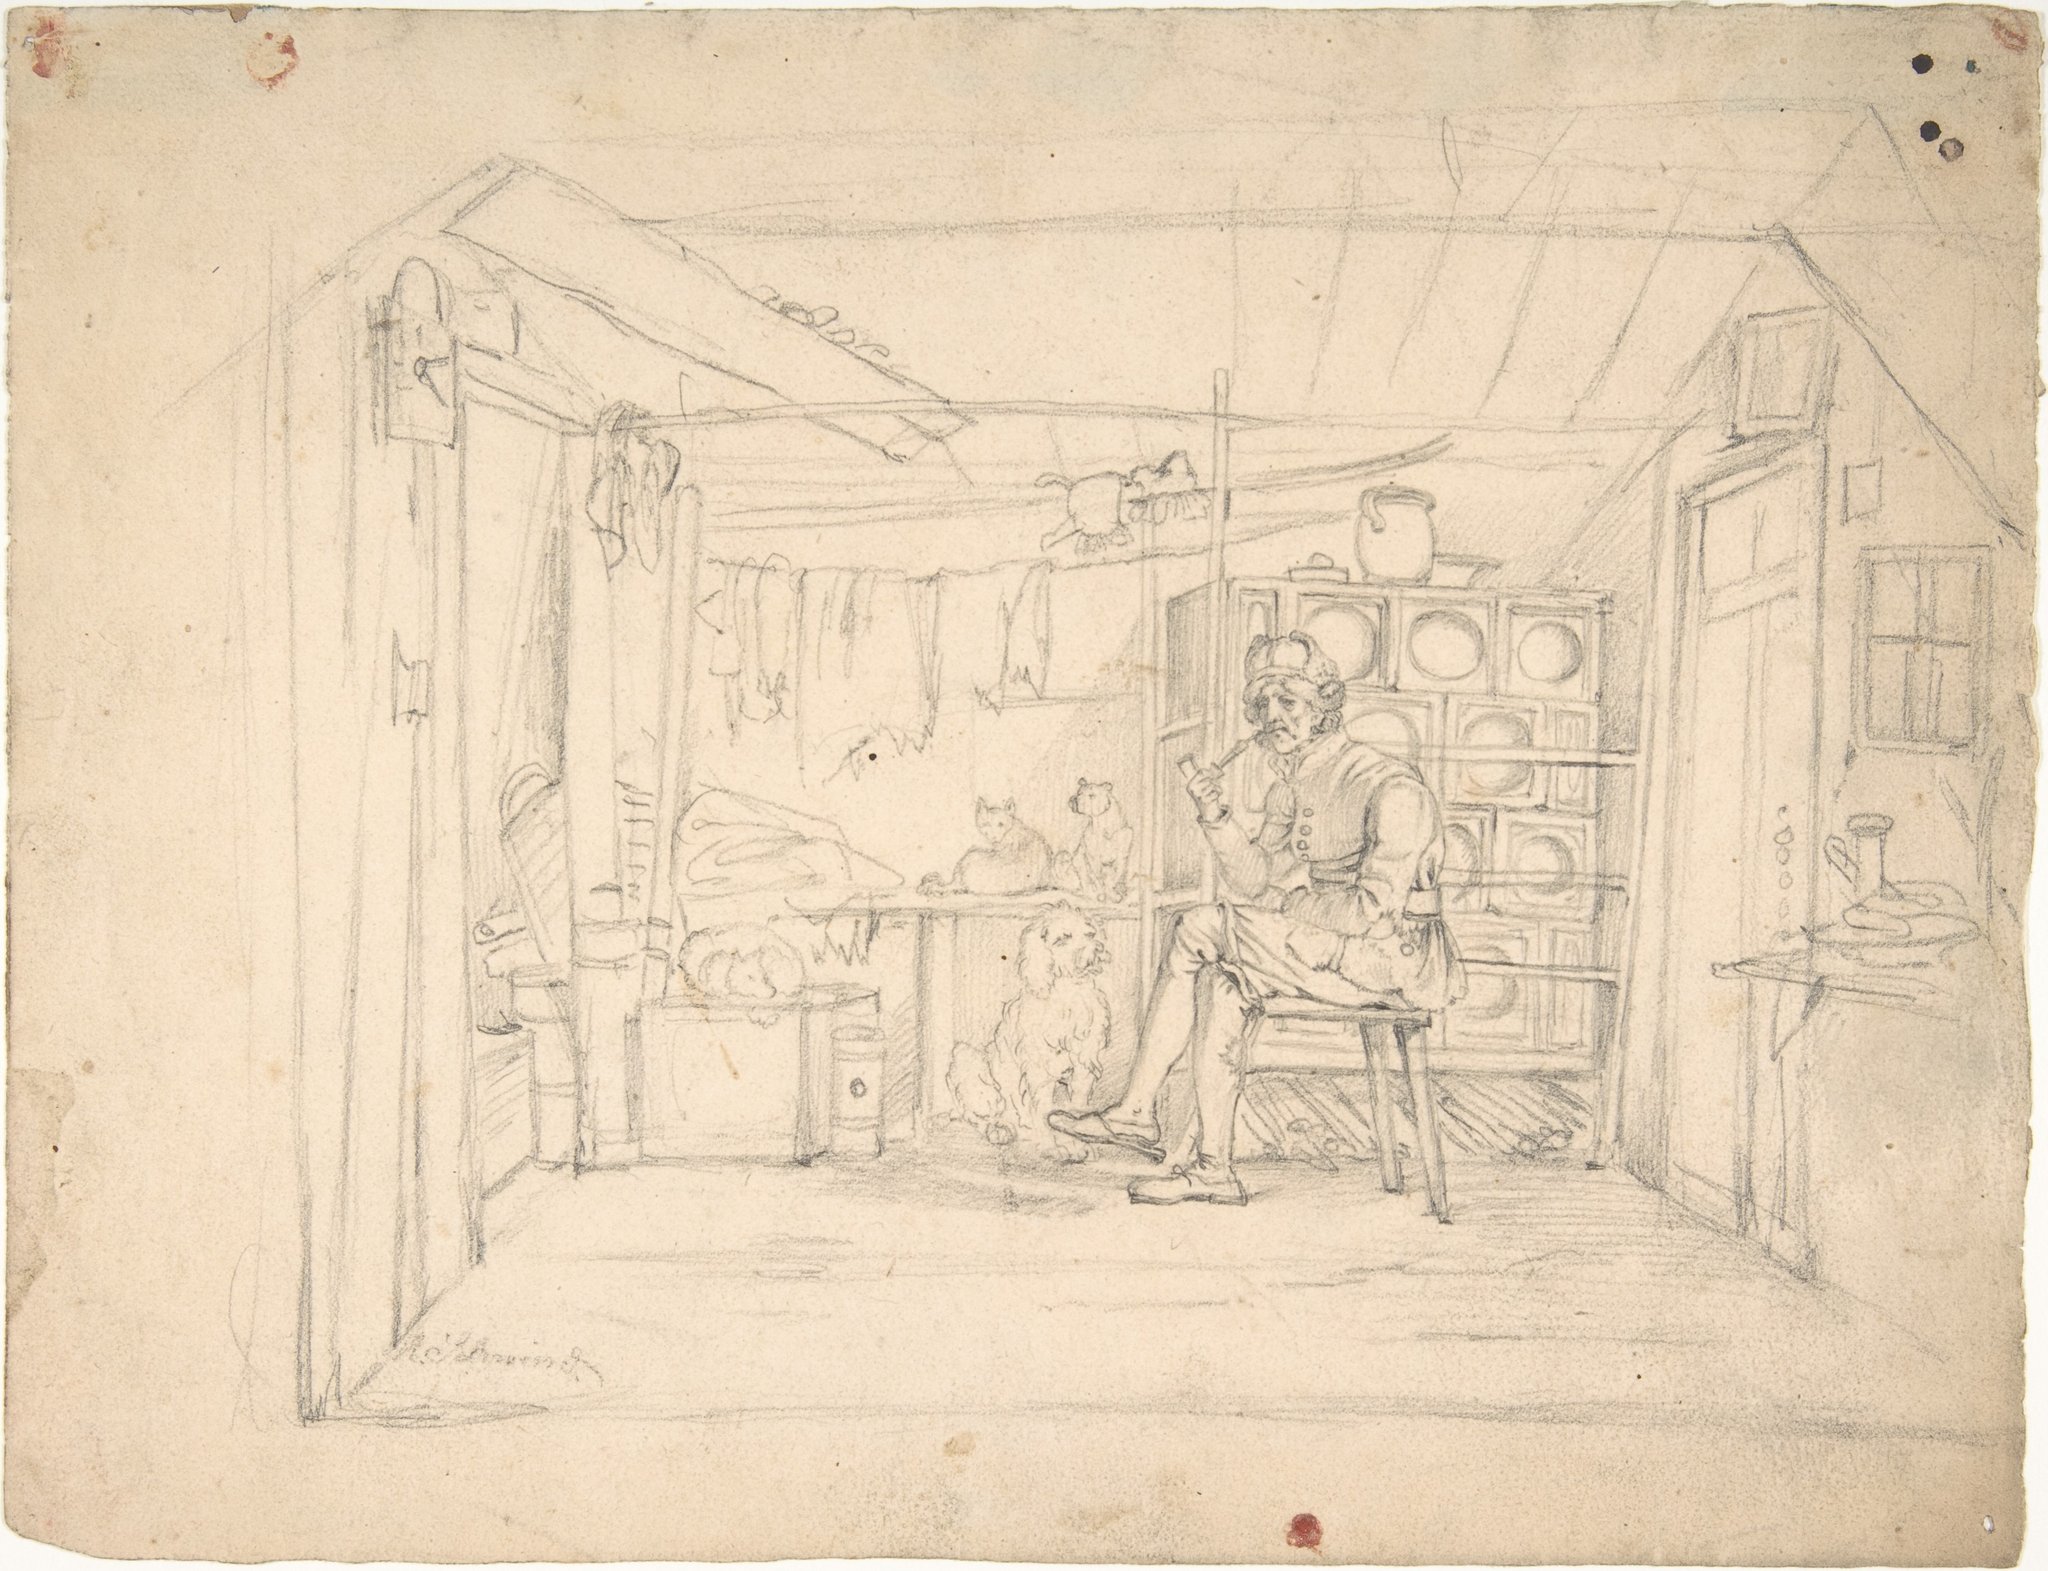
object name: drawing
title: Der Hundefreund (The Dog's Friend)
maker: moritz von schwind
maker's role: artist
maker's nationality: austrian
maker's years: 1804-1871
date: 1834-1866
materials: ink, lead, pencil, pigment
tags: interiors,men,dogs,clocks